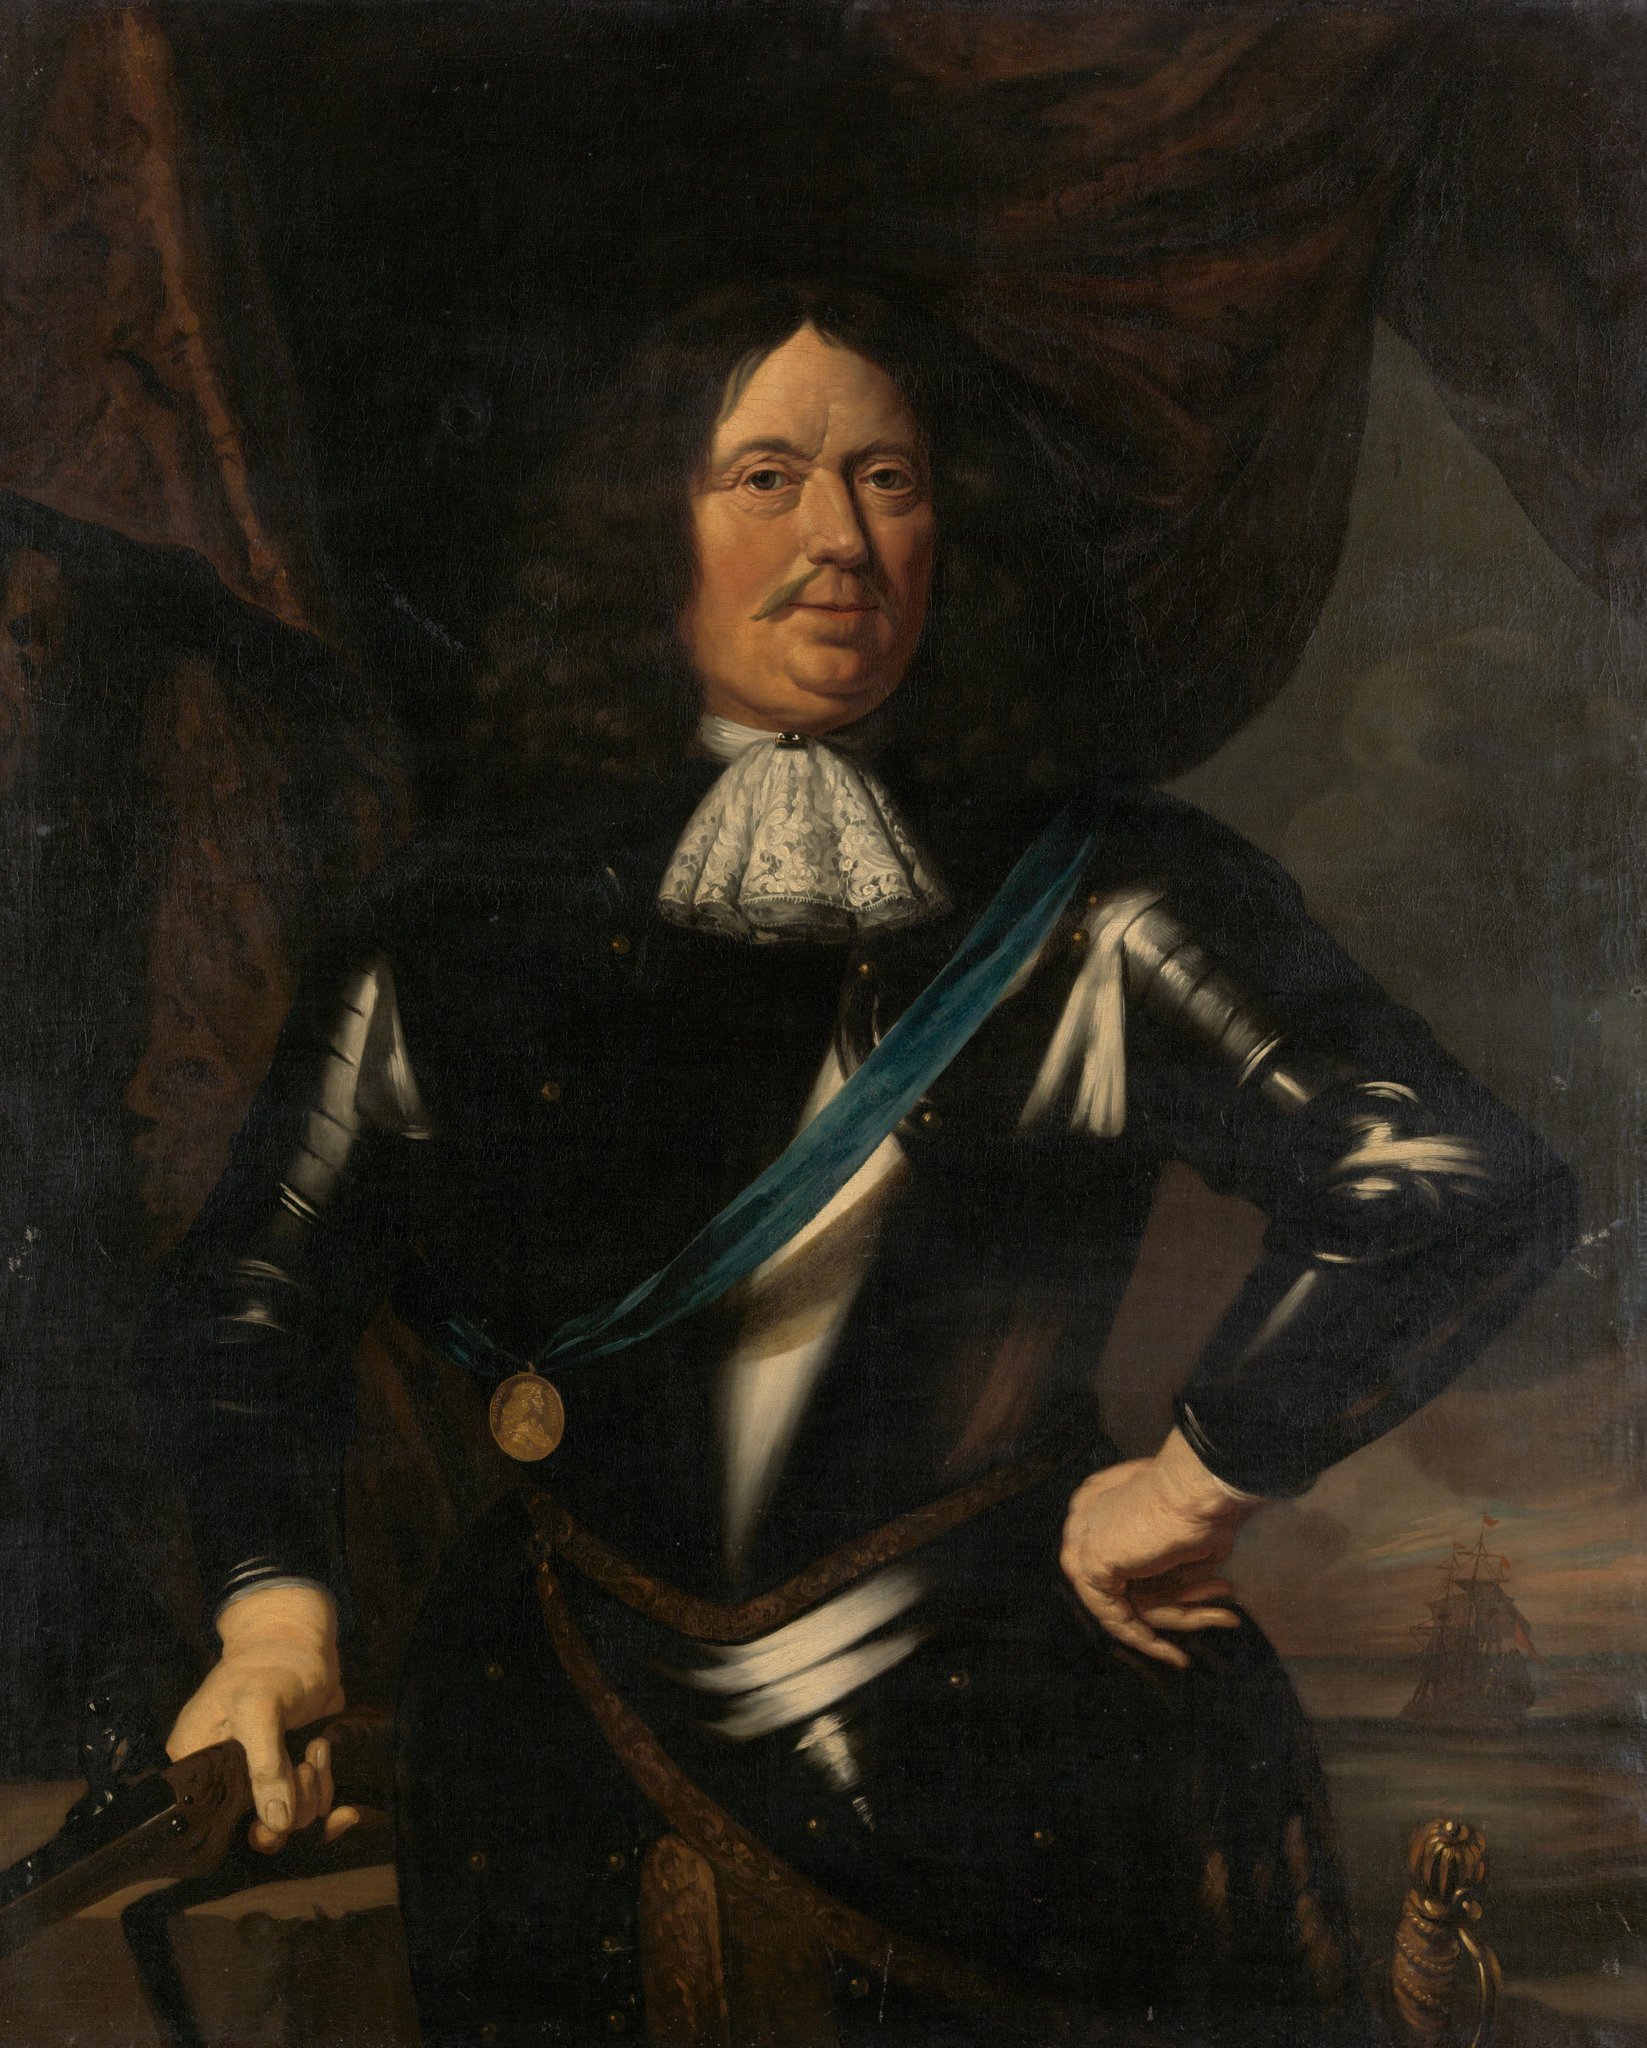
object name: painting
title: Portrait of an Admiral, possibly Adriaen Banckert, Vice-Admiral of Zeeland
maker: Anonymous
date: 1670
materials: canvas, oil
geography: northern netherlands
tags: middelburg, historical persons, commander-in-chief, admiral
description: Portret van een admiraal, vermoedelijk Adriaen Banckert (ca. 1615-84), vice-admiraal van Zeeland. Kniestuk, staande in wapenrusting met een pistool in de rechterhand, de linkerhand in de zij. Op de achtergrond een zeegezicht met een schip. Om de borst een lint met een portretmedaillon.